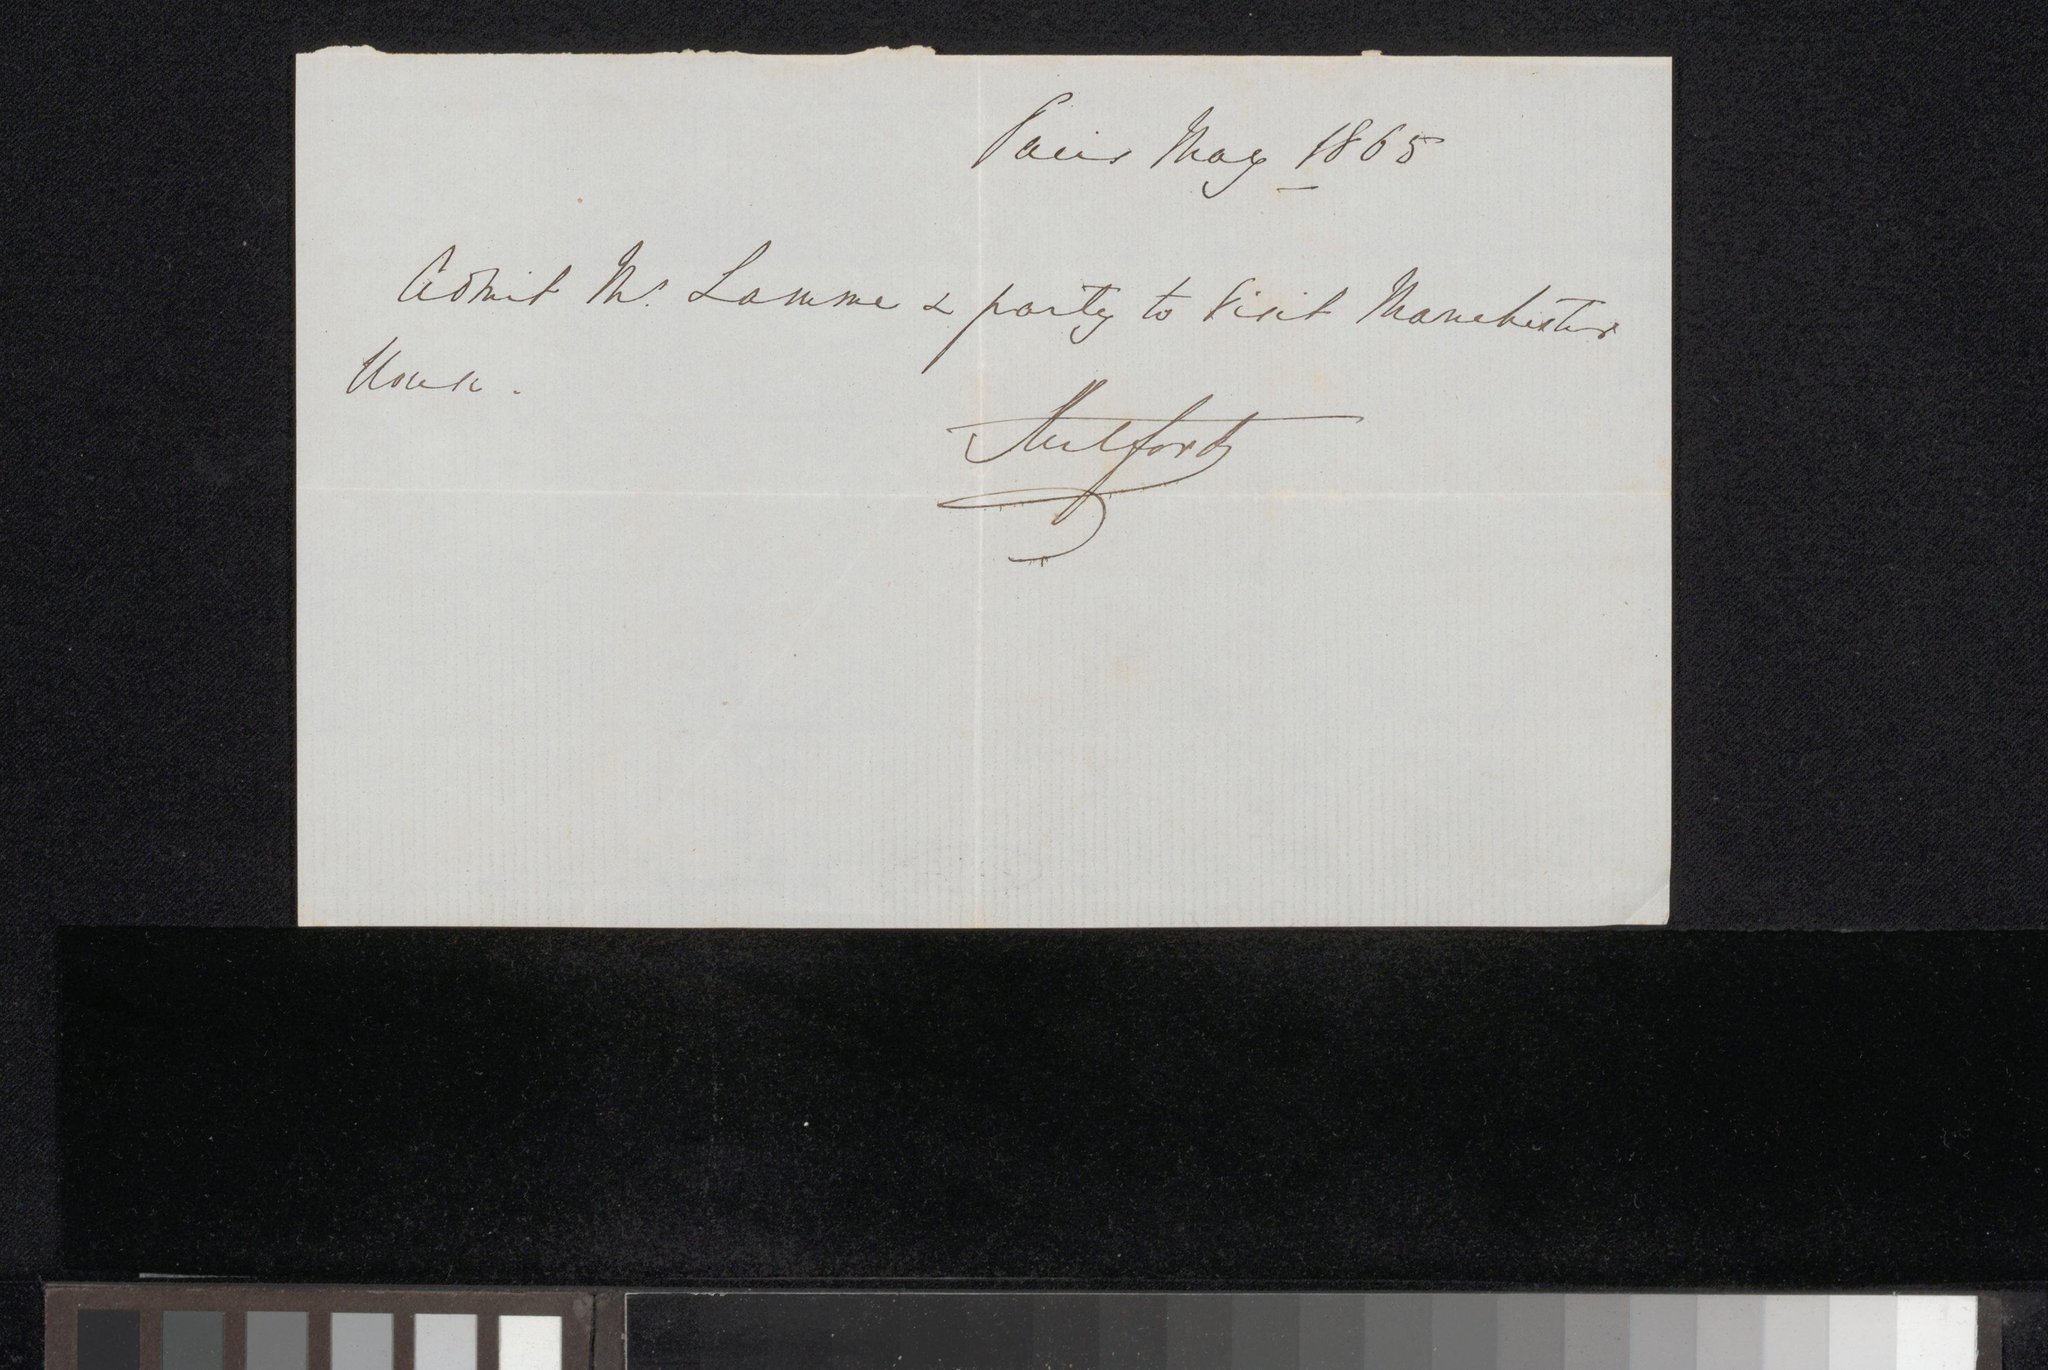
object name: admission ticket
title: Toegangskaart aan Ary Johannes Lamme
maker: richard seymour-conway (4e markies van hertford)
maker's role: kunstverzamelaar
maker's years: 1800-1870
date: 1805-1865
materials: ink, paper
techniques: pen, writing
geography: paris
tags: dordrecht, print maker, draughtsman, ary johannes lamme, art collecting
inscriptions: collector's mark: Lugt 2228